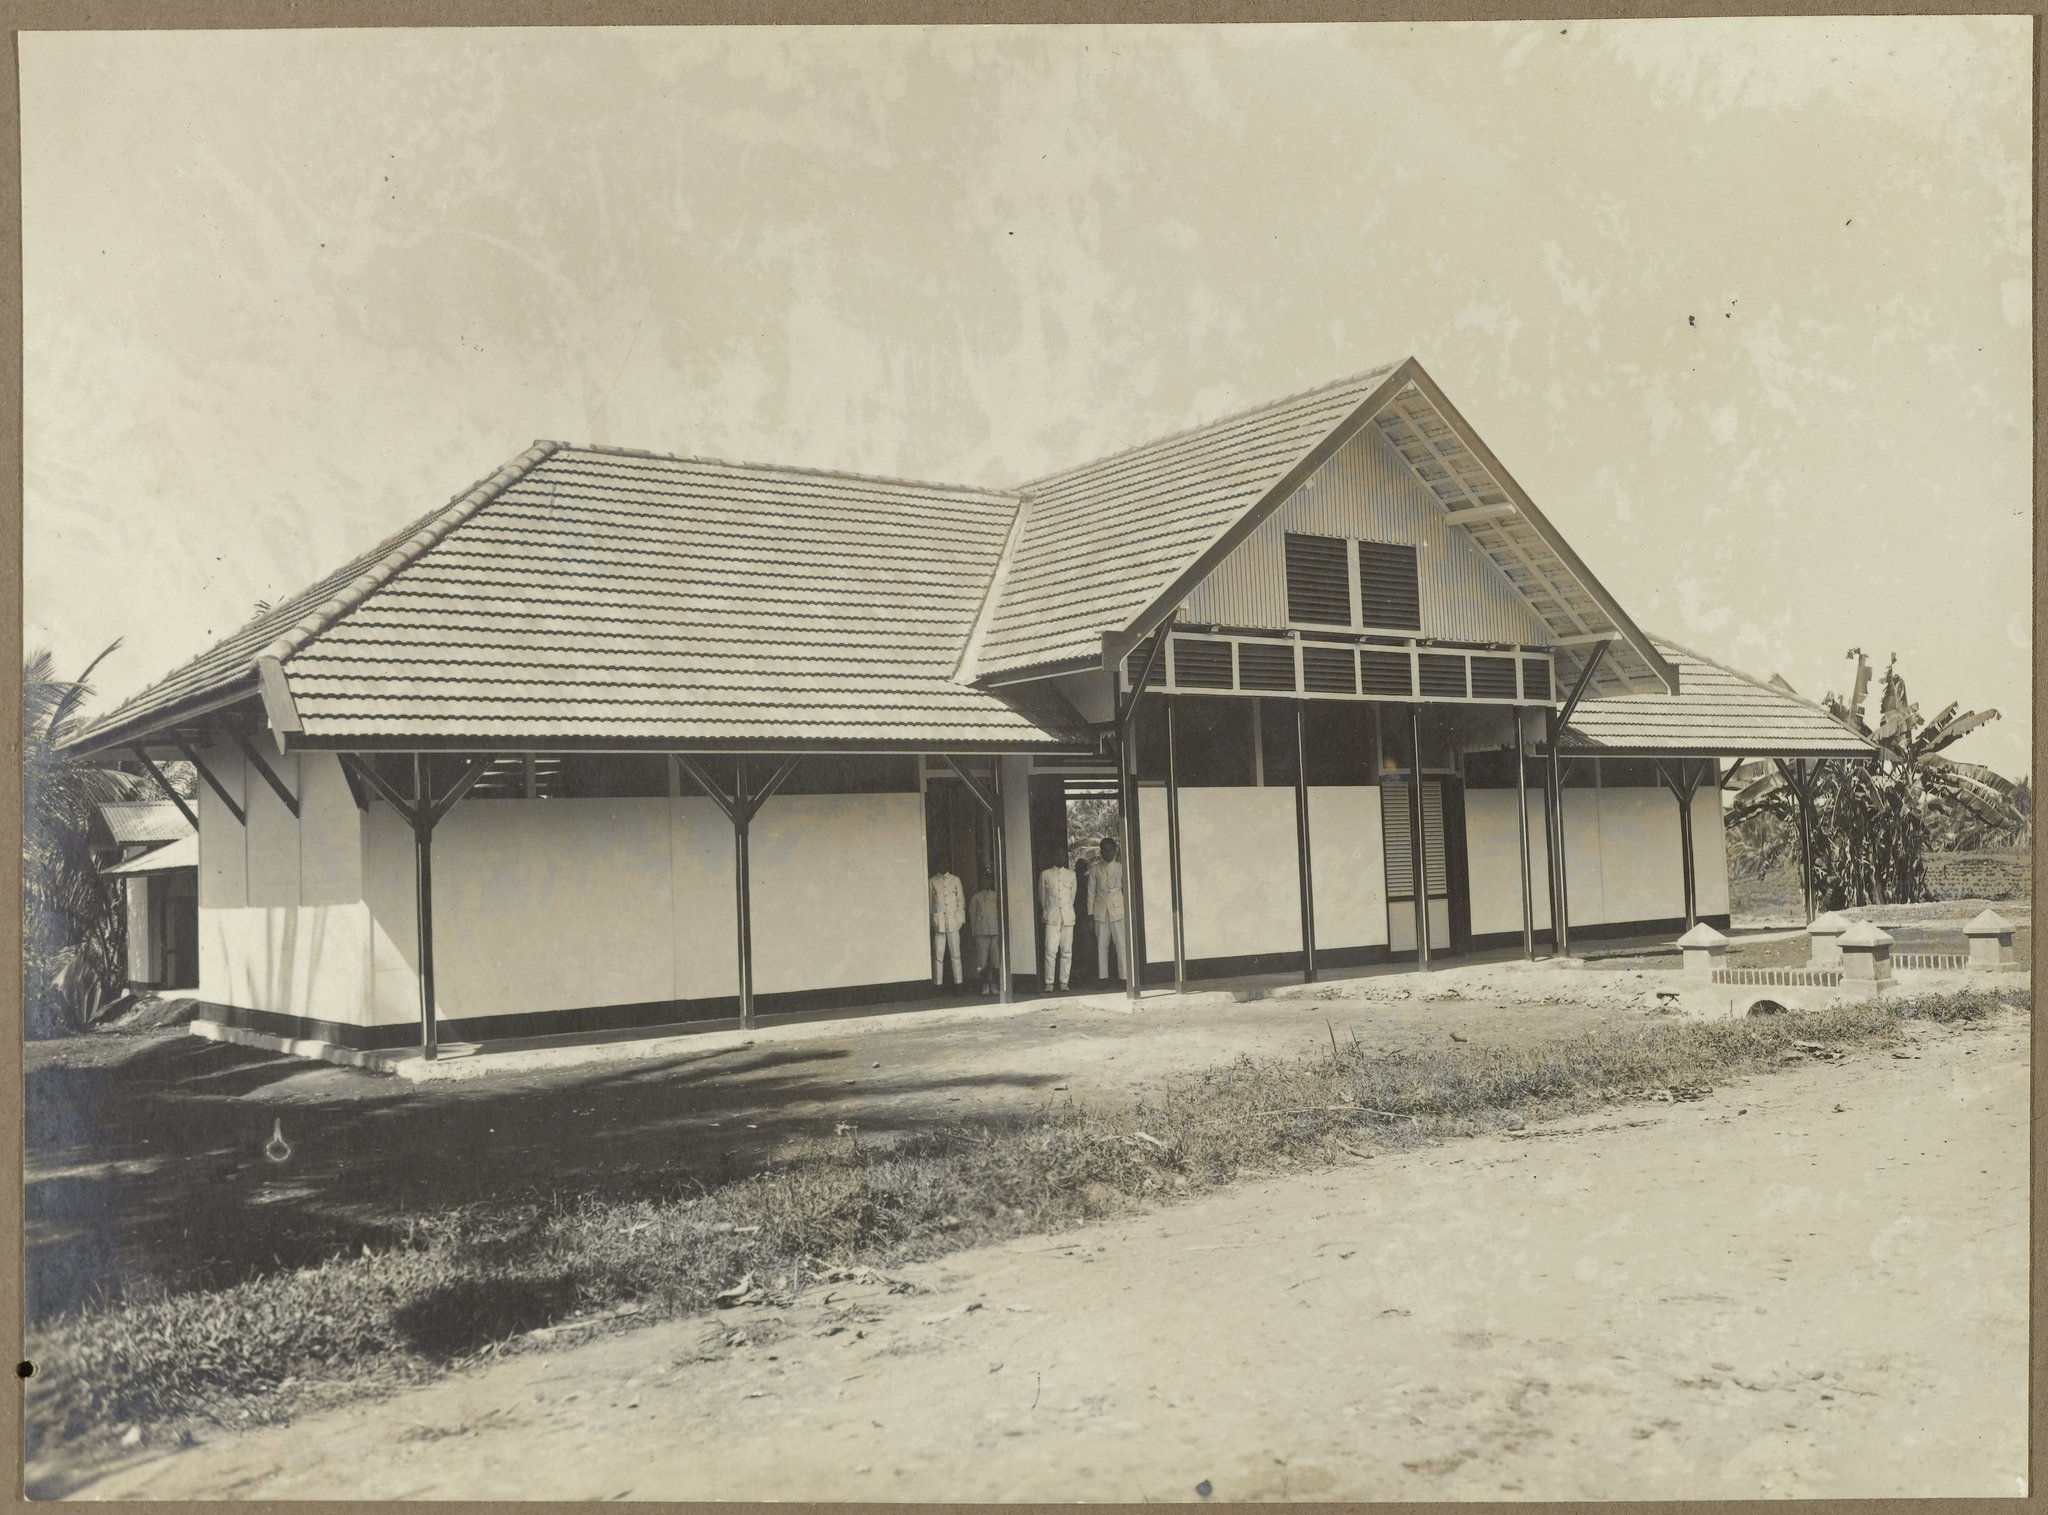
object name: photograph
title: Schoolgebouw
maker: Anonymous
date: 1914-1919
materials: photographic support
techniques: gelatin silver print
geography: medan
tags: representation of real building (either existing or having existed), architecture, elementary school; class, form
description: De oplevering van een nieuw schoolgebouw, waarschijnlijk te Medan, gebouwd door Bennink en Riphagen. Foto in het fotoalbum van het Nederlandse architectenbureau en aannemersbedrijf Bennink en Riphagen te Medan in de jaren ca. 1914-1919.